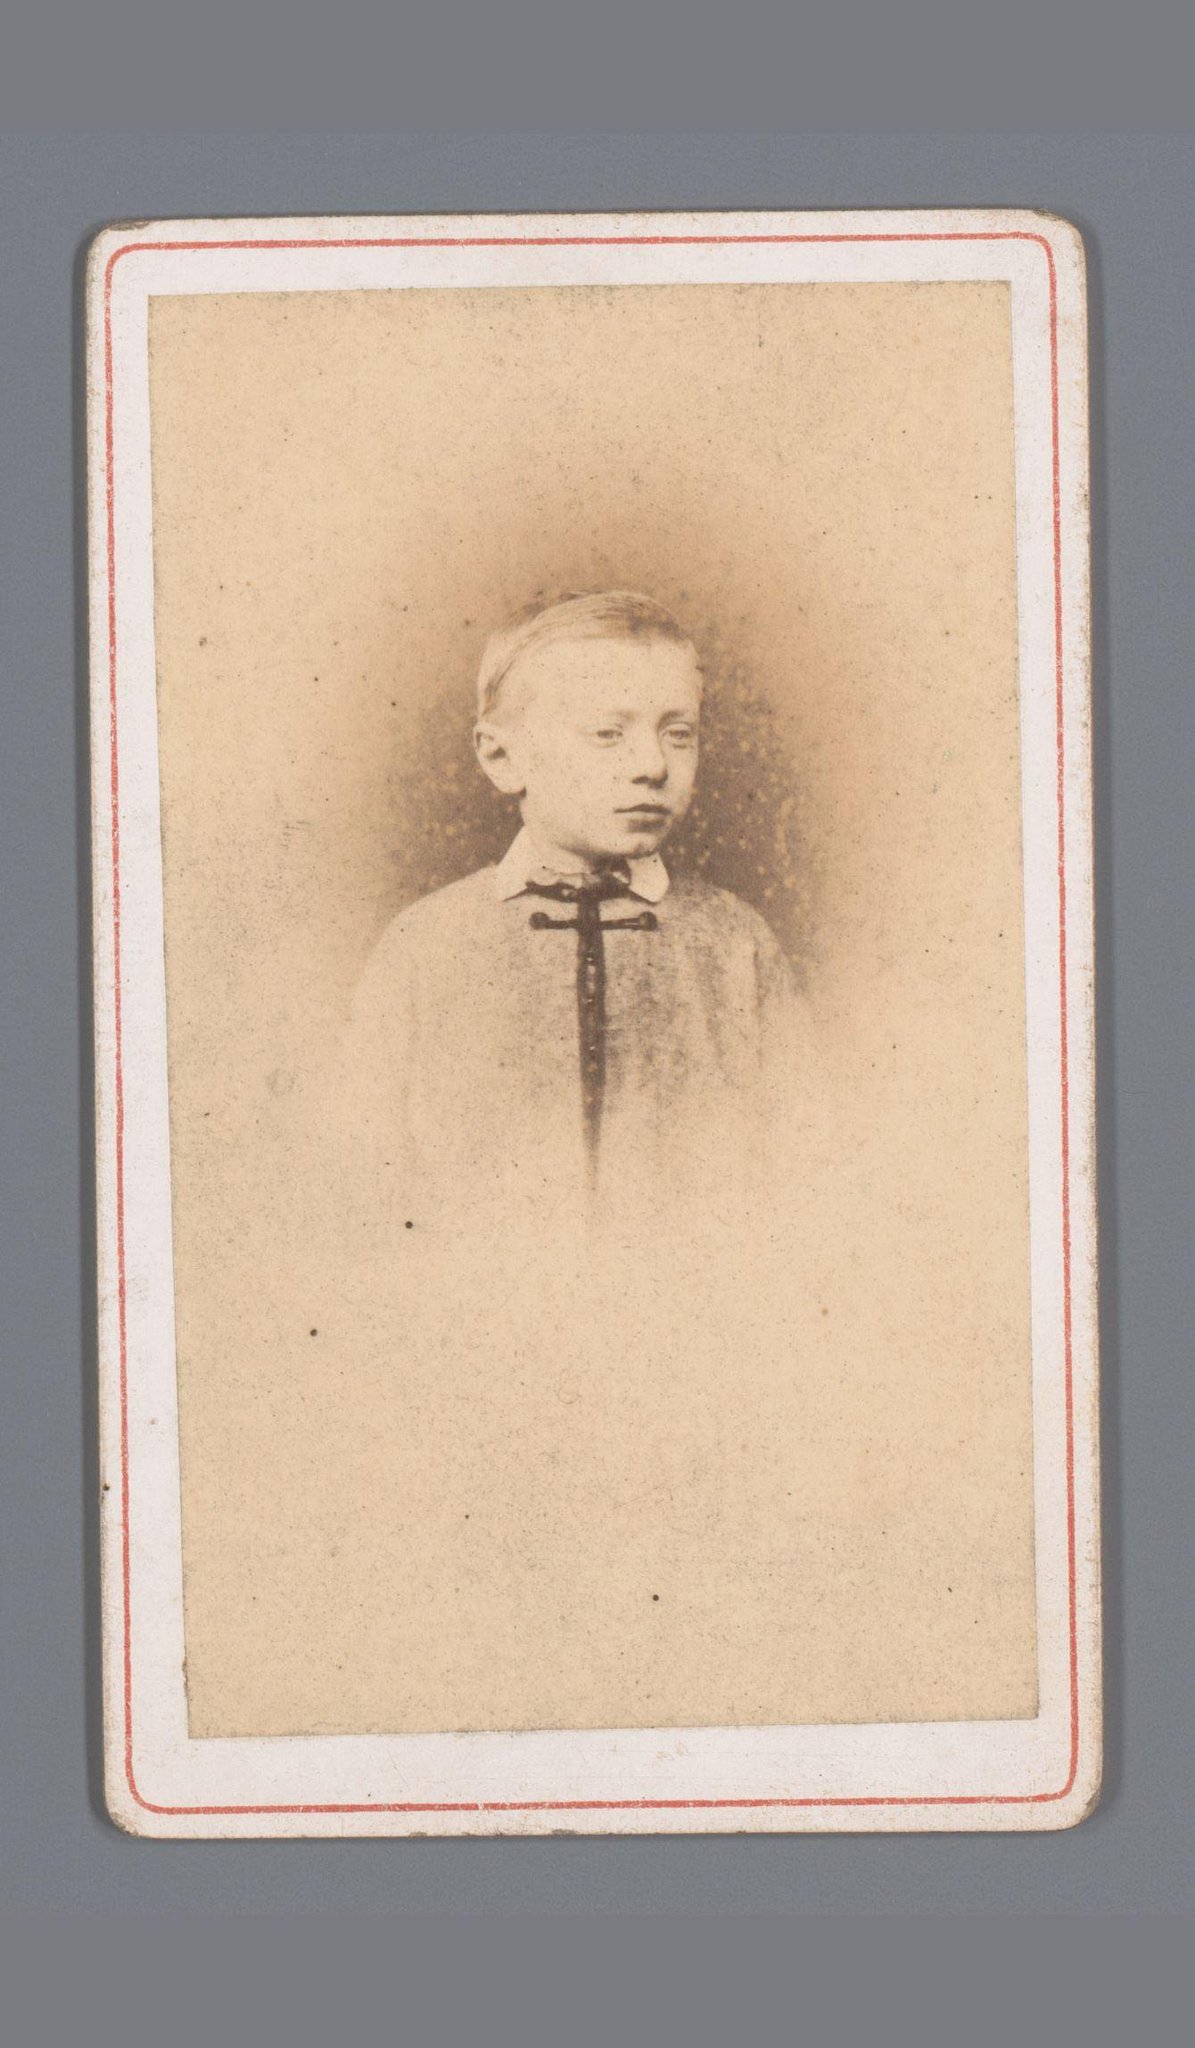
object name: photograph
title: Portret van een onbekende jongen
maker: raverdy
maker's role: fotograaf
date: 1855-1885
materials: cardboard, paper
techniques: albumen print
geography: valenciennes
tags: boy (child between toddler and youth), anonymous historical person portrayed